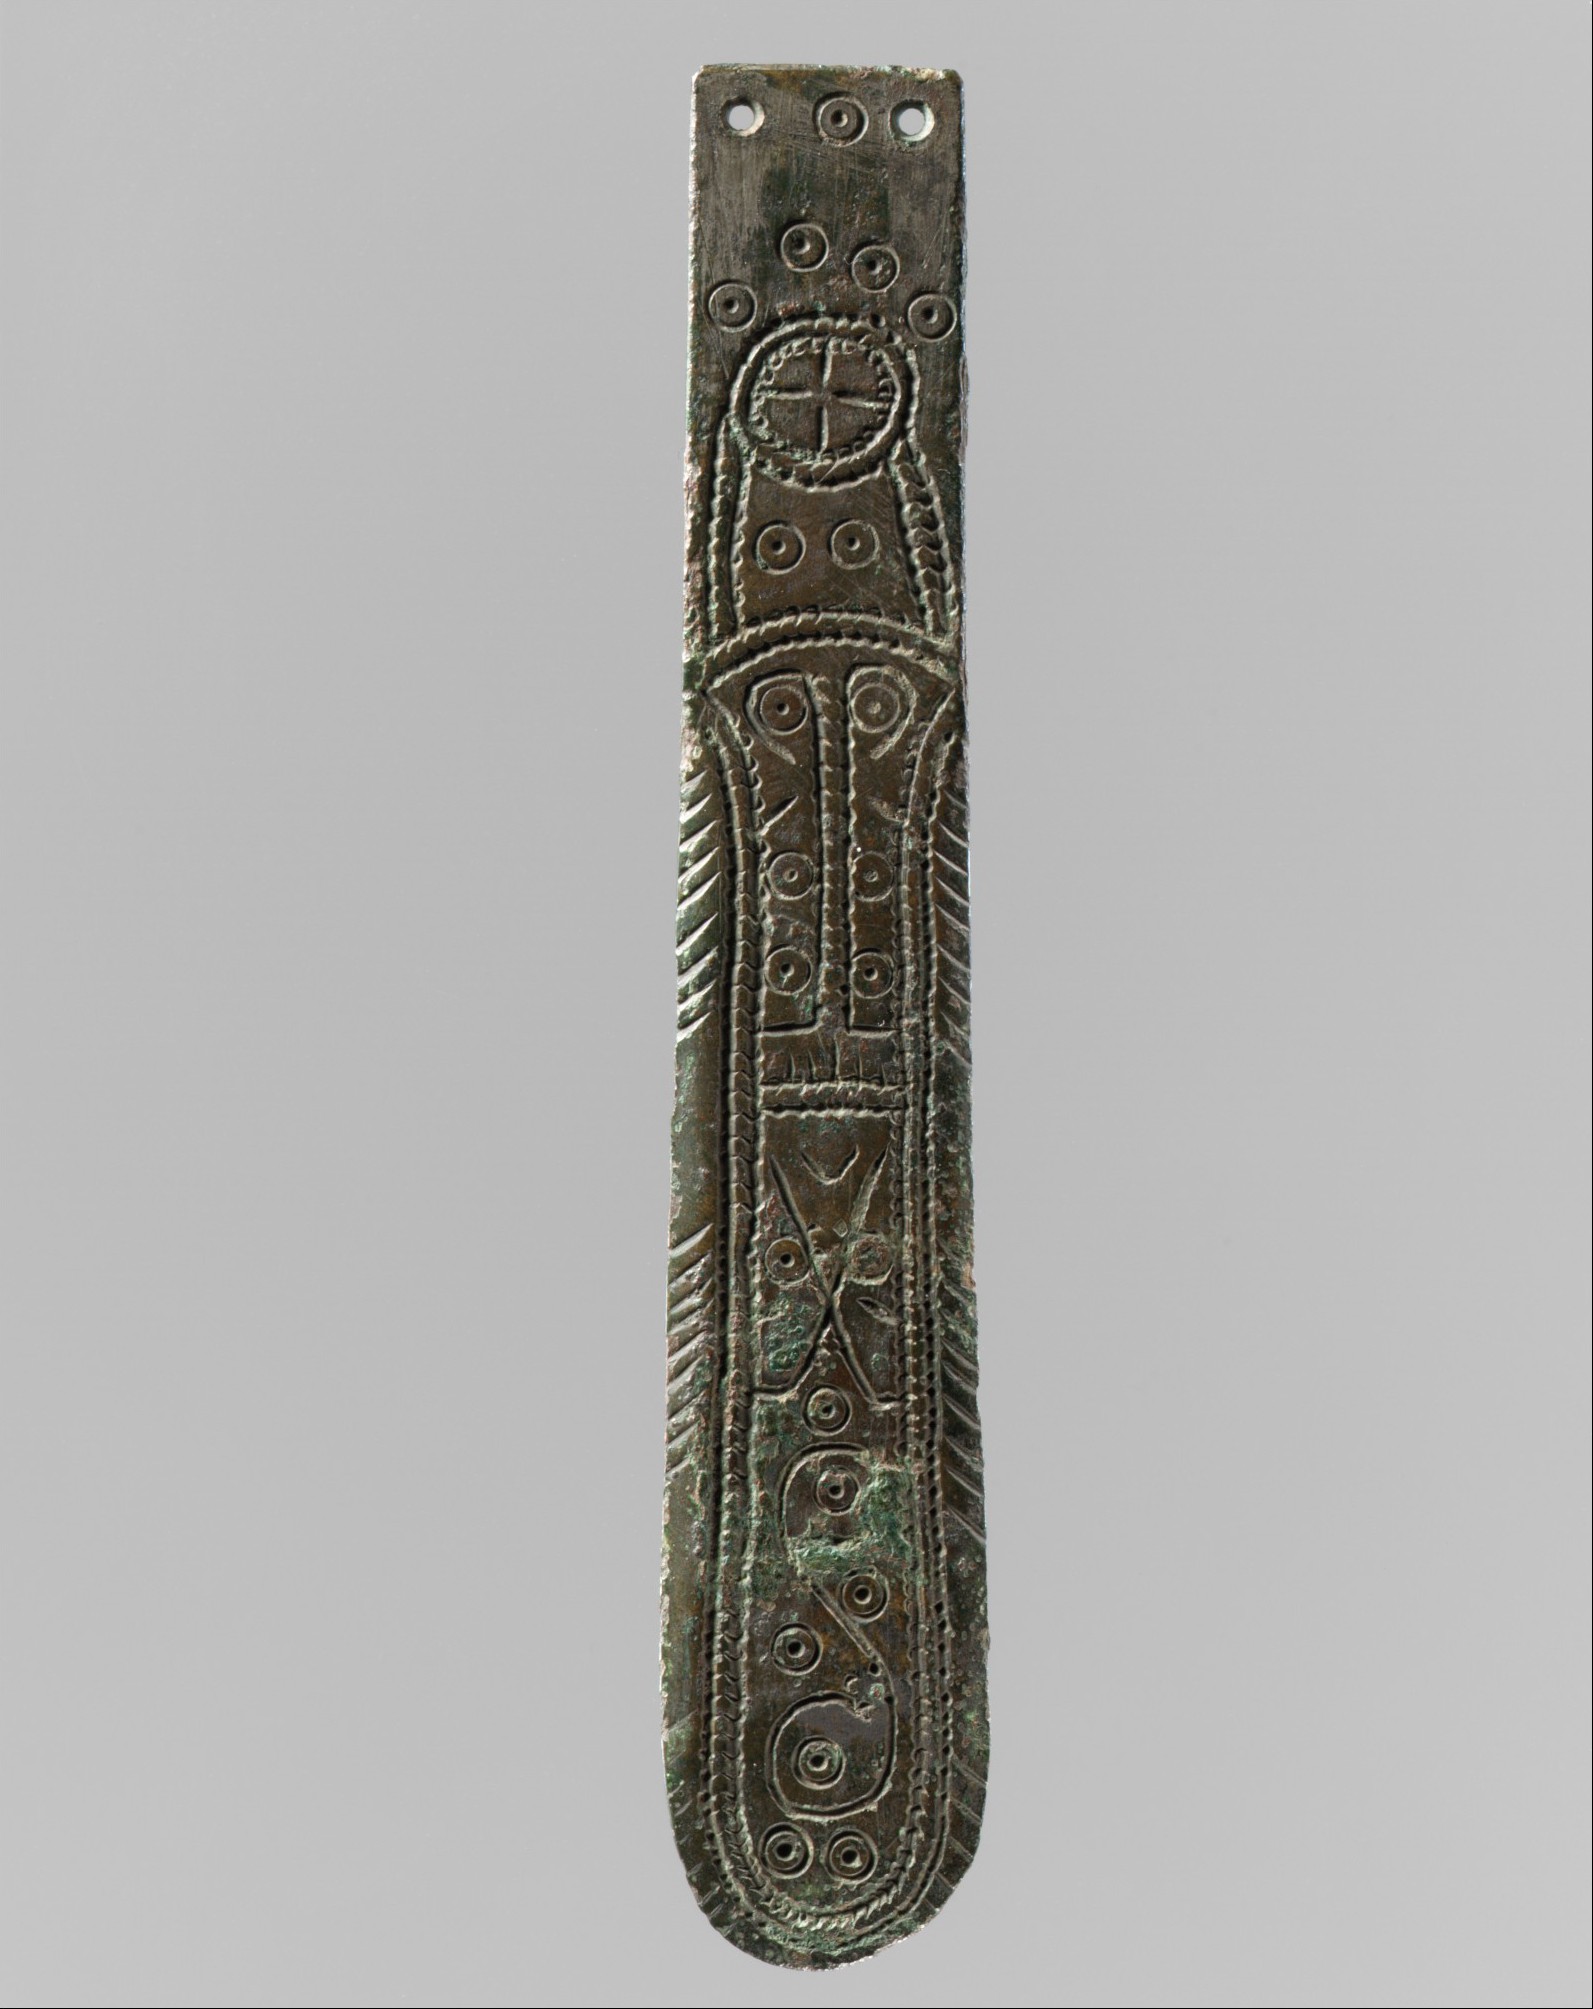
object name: strap end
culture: allemanic or frankish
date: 650-700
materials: bronze, tin